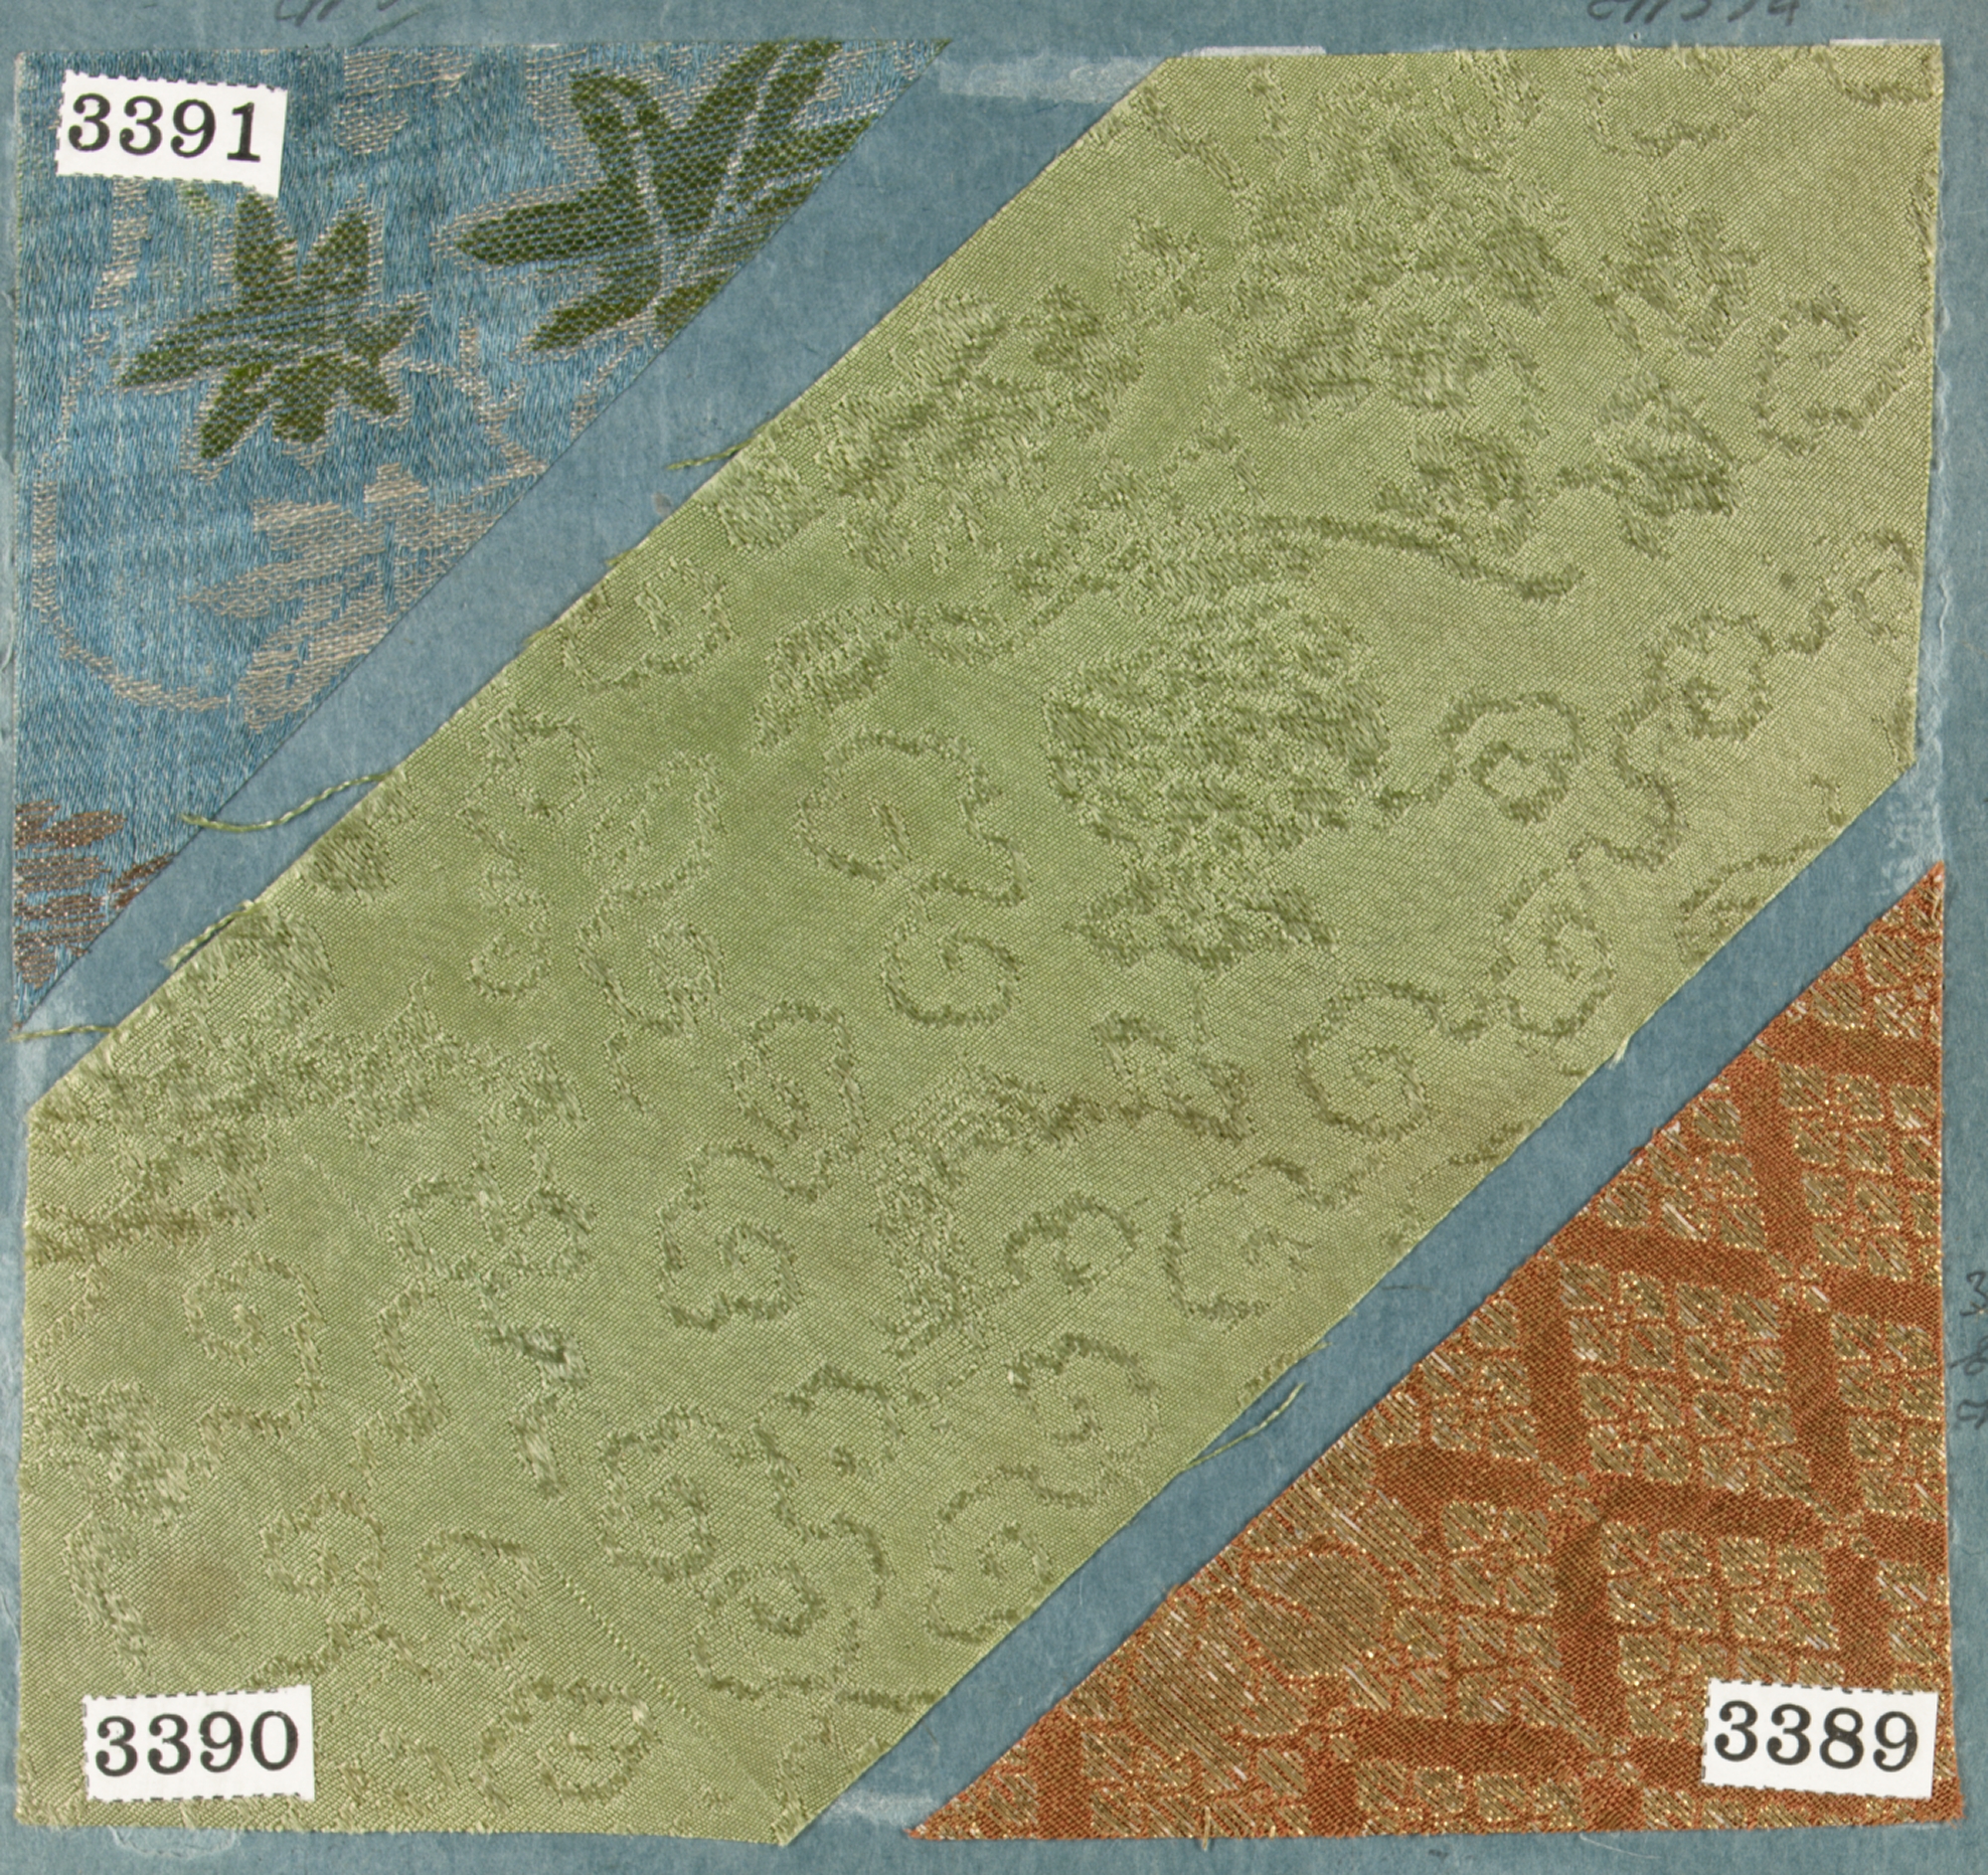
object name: textile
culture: japanese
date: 1801-1900